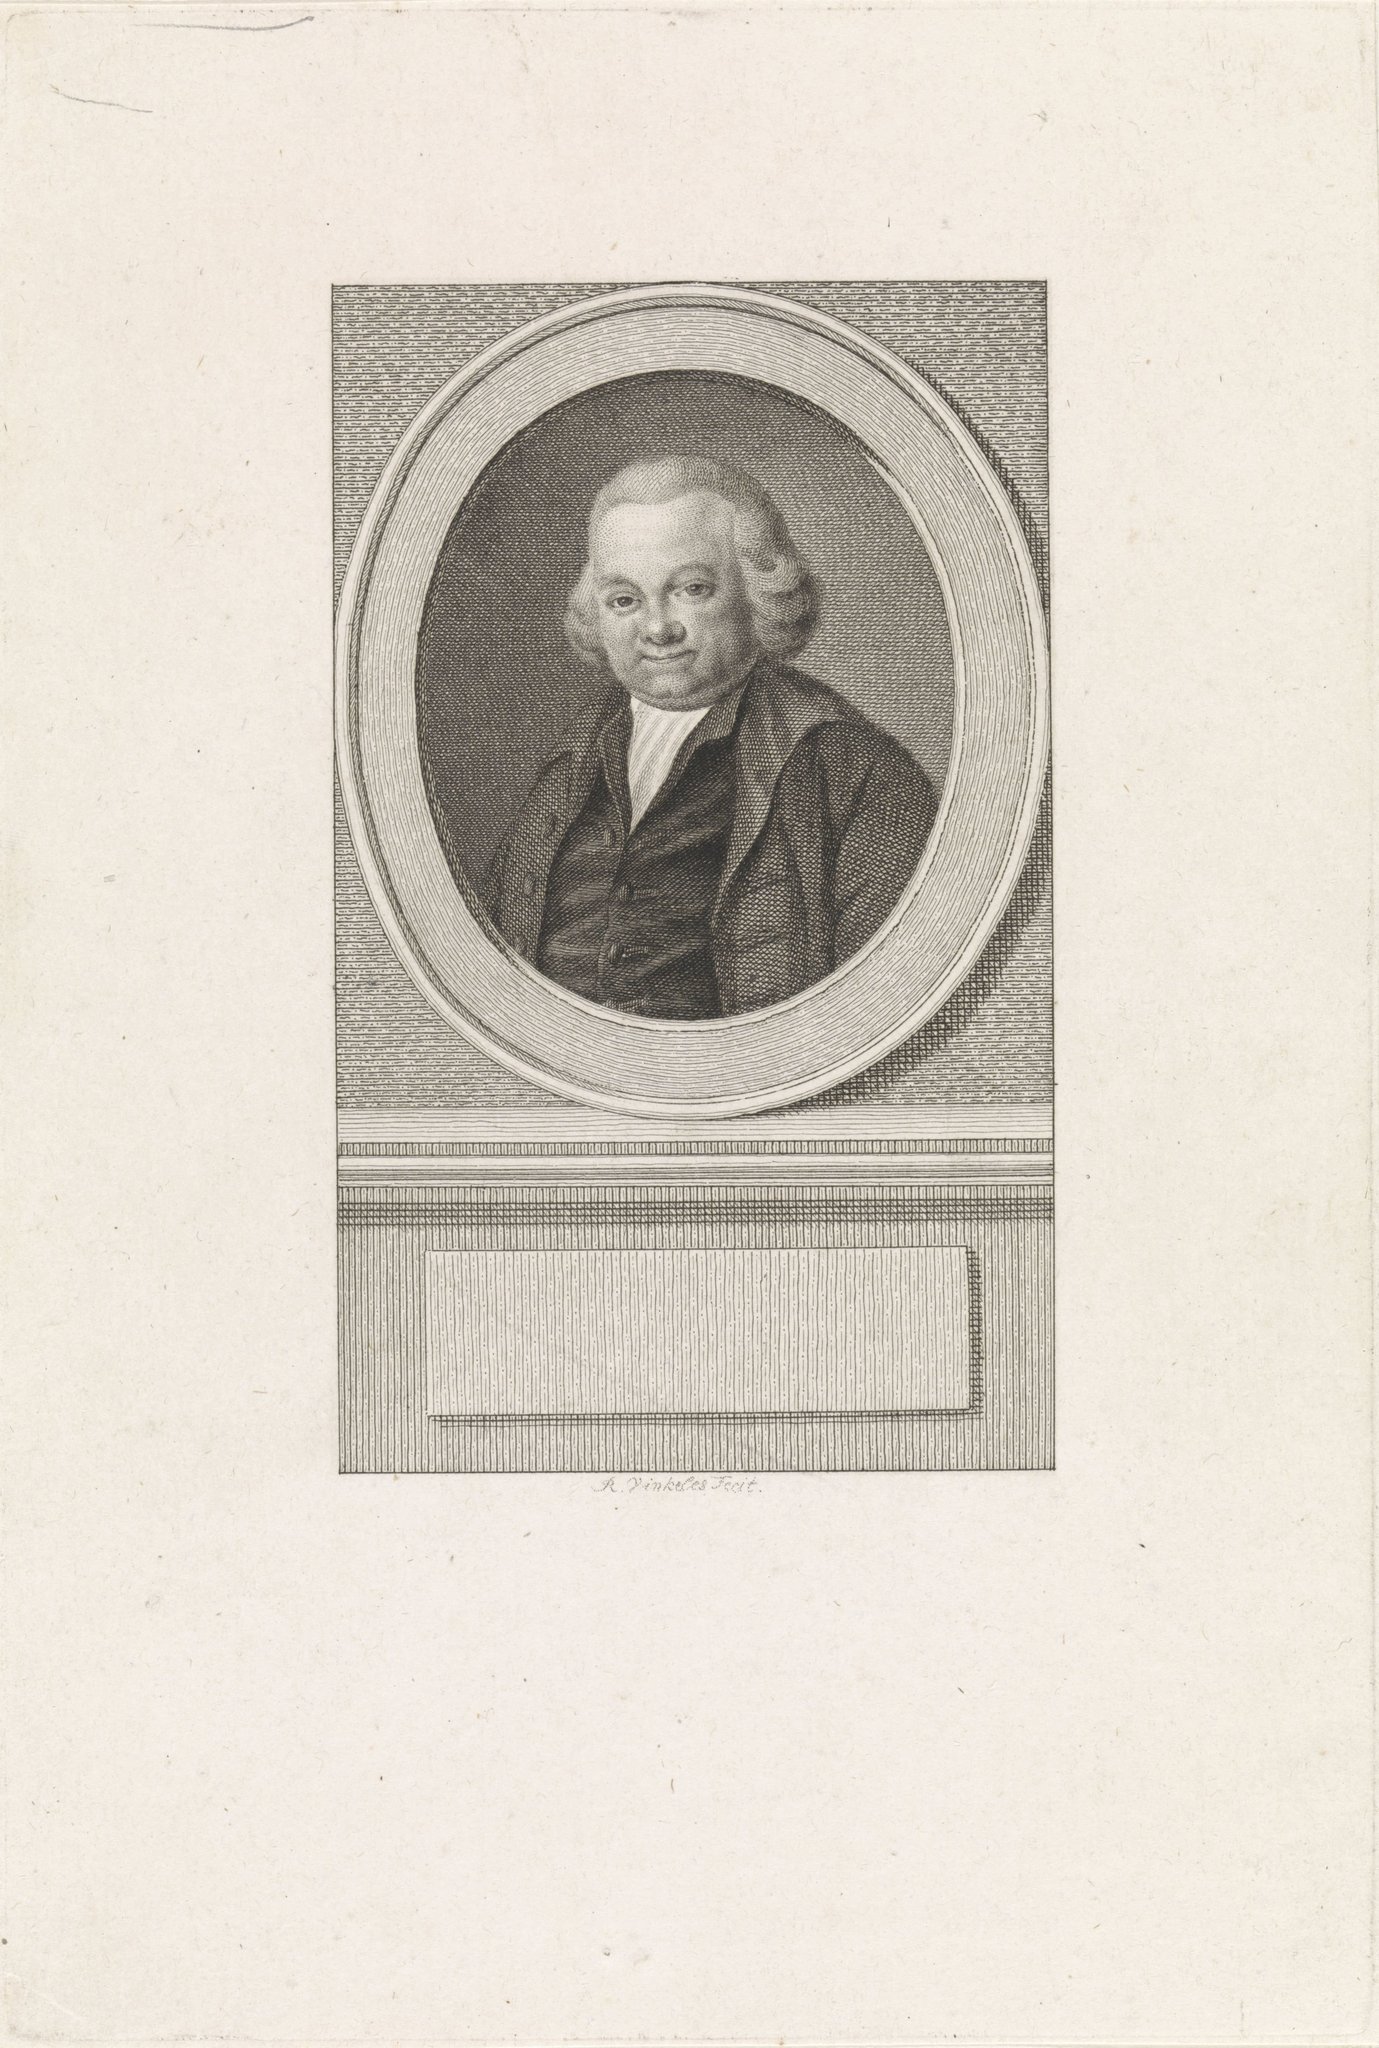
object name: print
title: Portret van Jeronimo de Bosch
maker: reinier vinkeles (i)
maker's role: draughtsman, print maker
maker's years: 1741-1816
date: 1786-1809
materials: paper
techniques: engraving, etching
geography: amsterdam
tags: jeronimo de bosch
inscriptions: collector's mark: Lugt 2228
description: Latere staat prent gebruikt in: Wagenaar, Jan. Vaderlandsche historie, (...) ten vervolge van Wagenaars Vaderlandsche historie. Dl. 1-43. Amsterdam: Johannes Allart, 1786-1809.